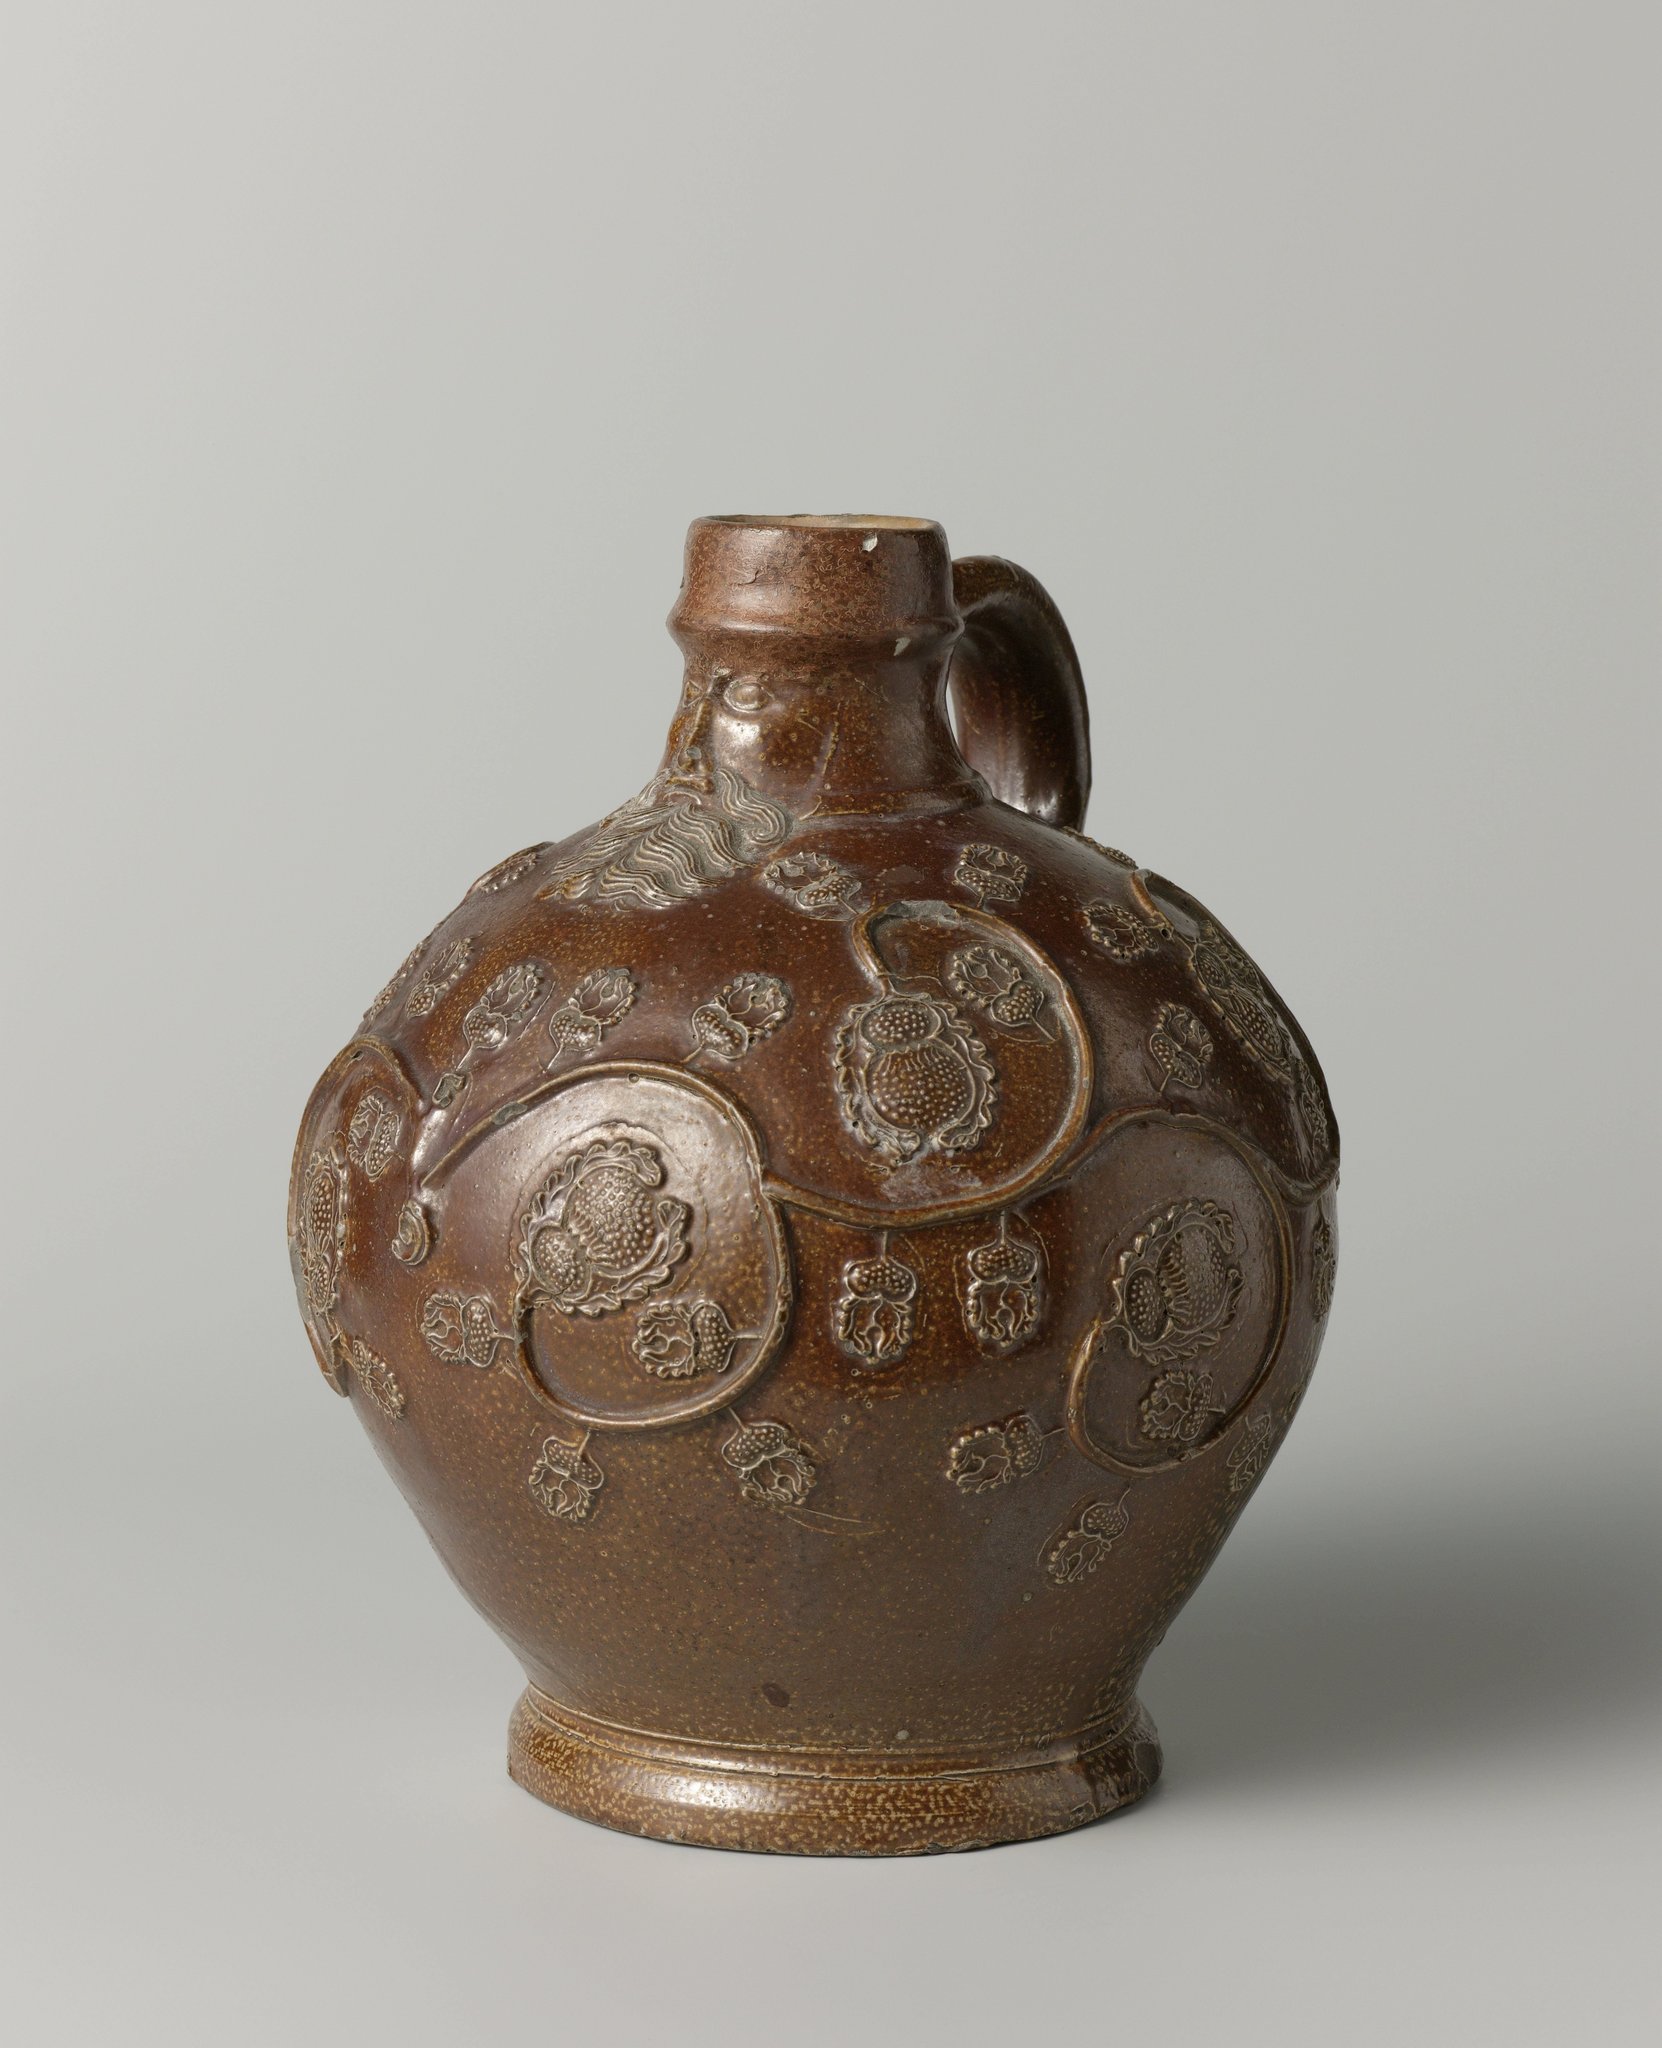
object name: jug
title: Jug (Bartmann jug) with floral scrolls and stars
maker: Anonymous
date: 1540-1570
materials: engobe, glaze, stoneware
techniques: firing, forming, relief, turning, vitrification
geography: frechen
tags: foliage, tendrils, branches ~ ornament, beard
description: Kruik (baardmankruik) van steengoed op standvlak met een eivormig lichaam en smalle nek. Een dubbel C-vormig oor is bevestigd aan de nek en de schouder. Profielen op de nek. Bedekt met een bruine engobe. Op de buik in reliëf gedrukte en opgelegde bloemranken. De nek met twee banden met sterren en op de basis, doorlopend op de schouder, een baardman. Keulen/ Frechen.